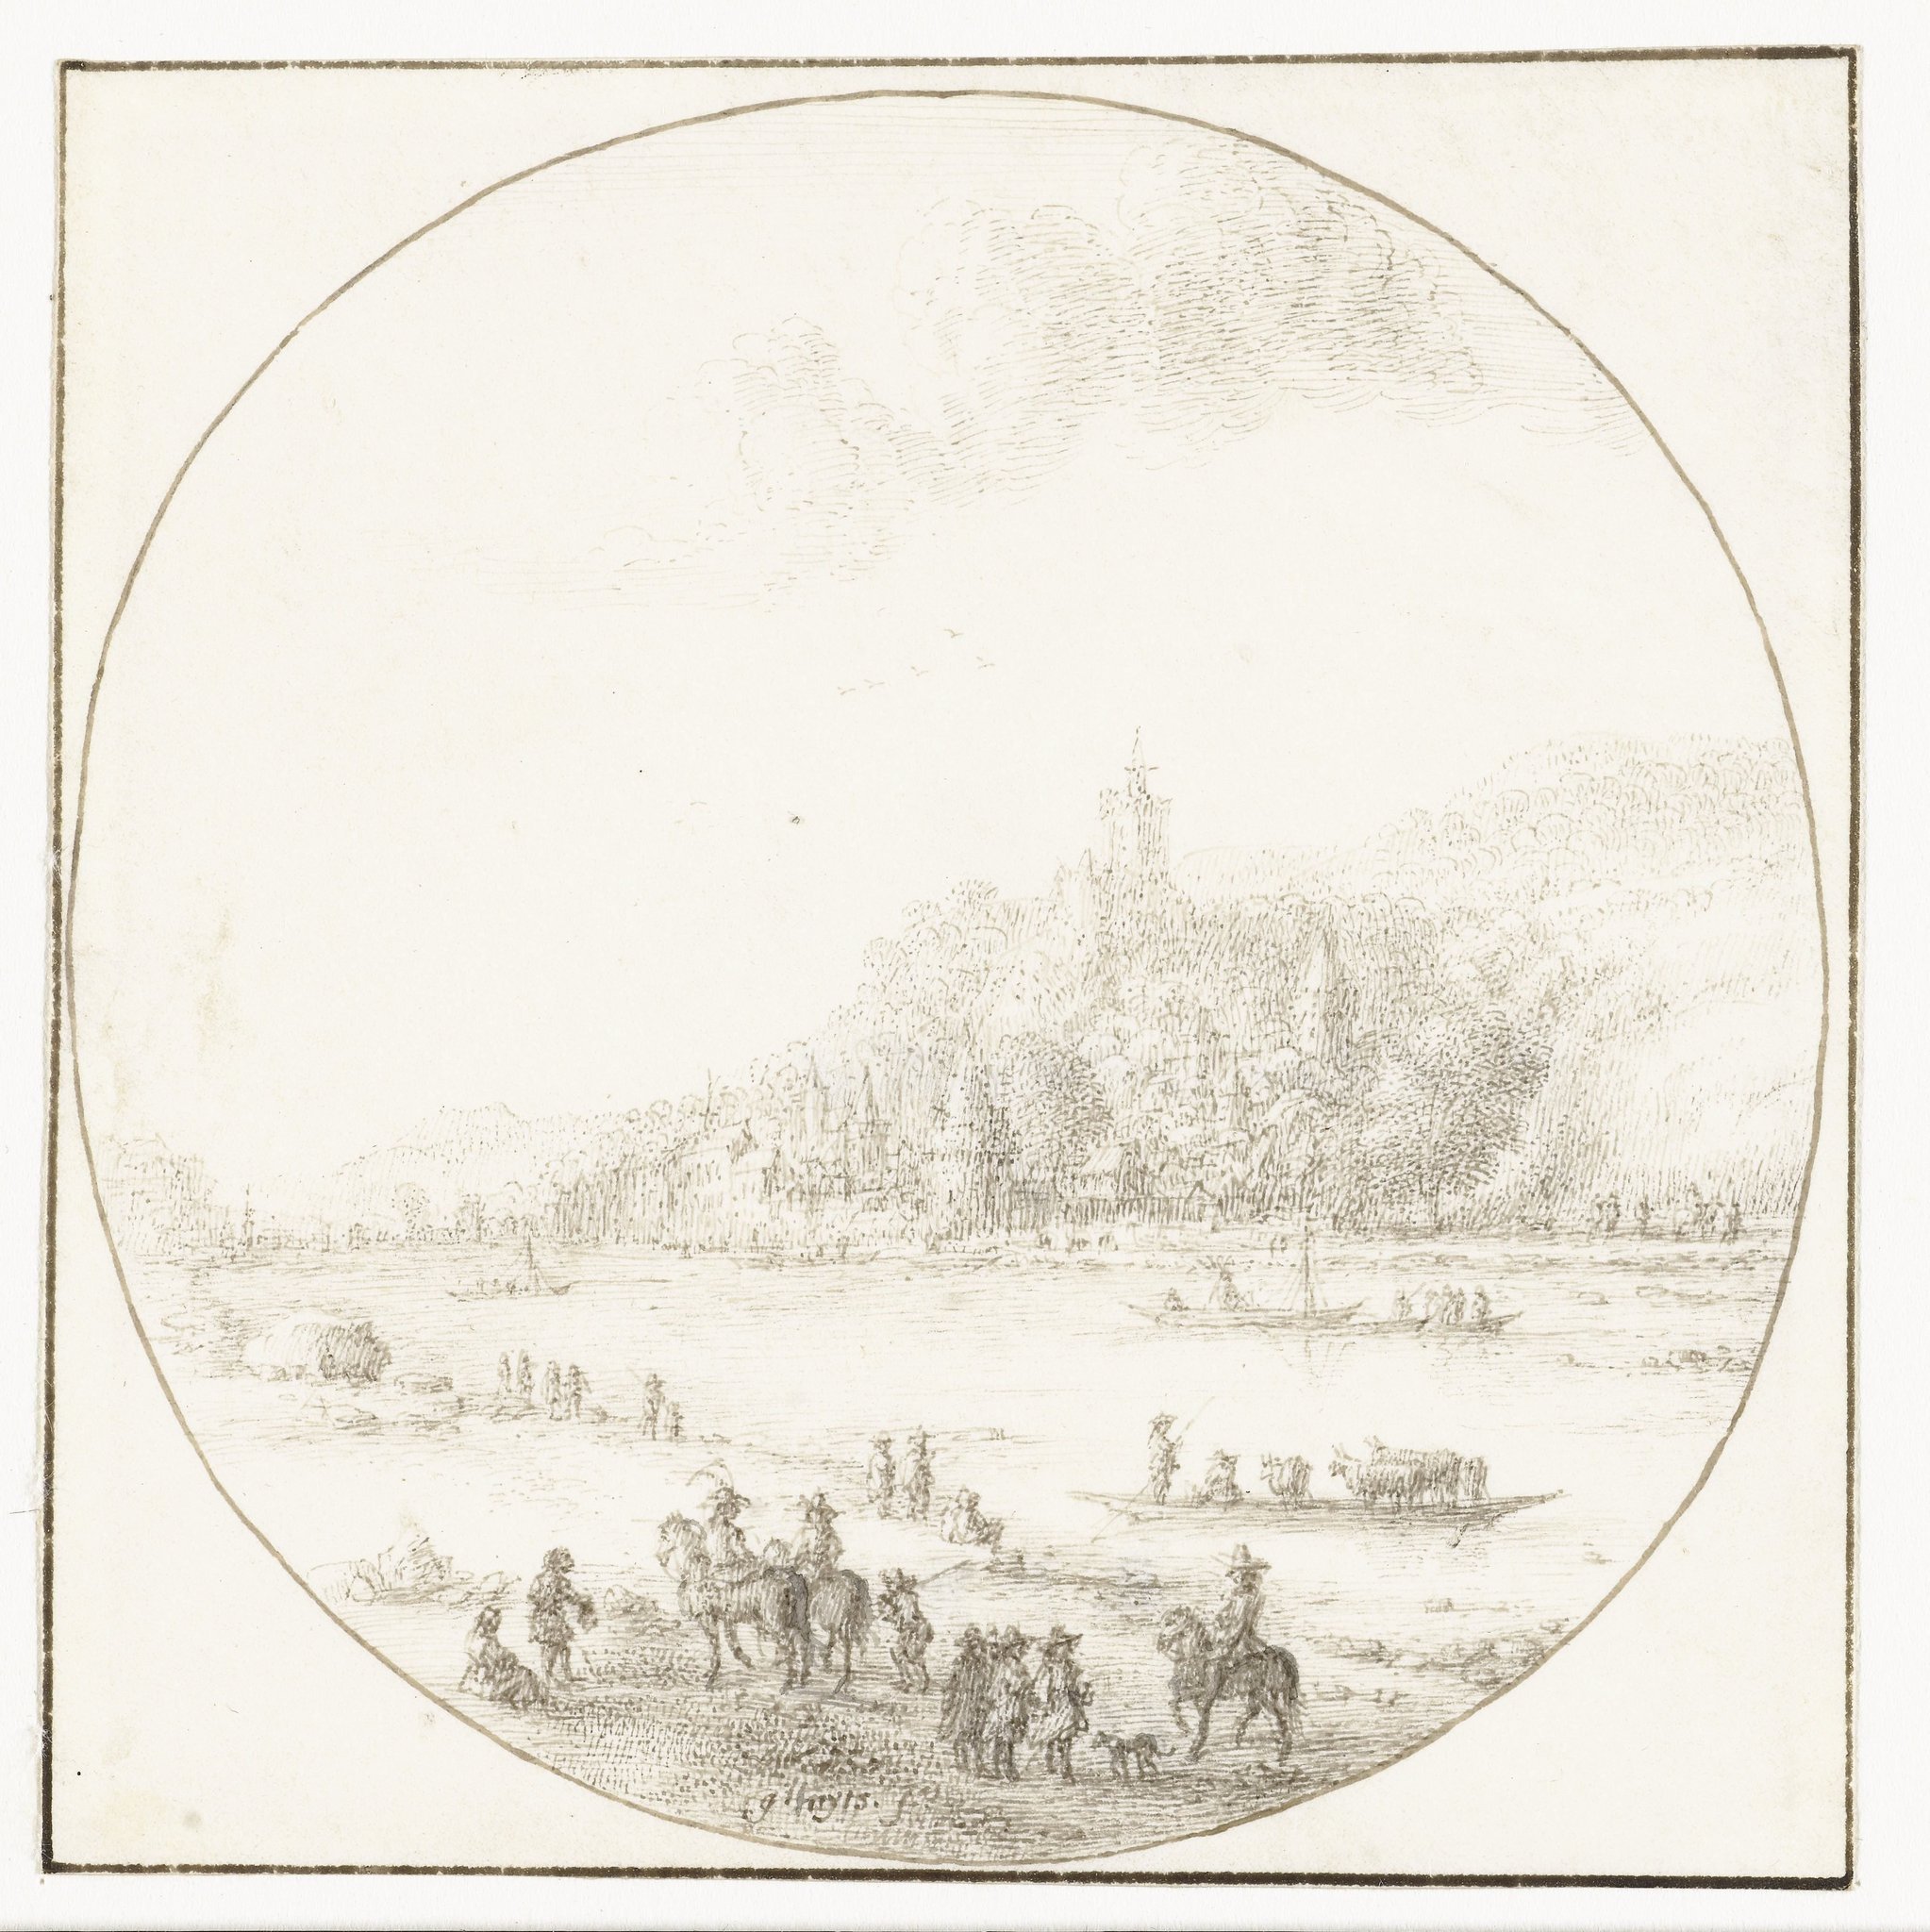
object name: drawing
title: Rivierlandschap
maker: gilles neyts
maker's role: draughtsman, print maker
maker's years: 1623-1687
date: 1633-1687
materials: ink, parchment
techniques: pen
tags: river